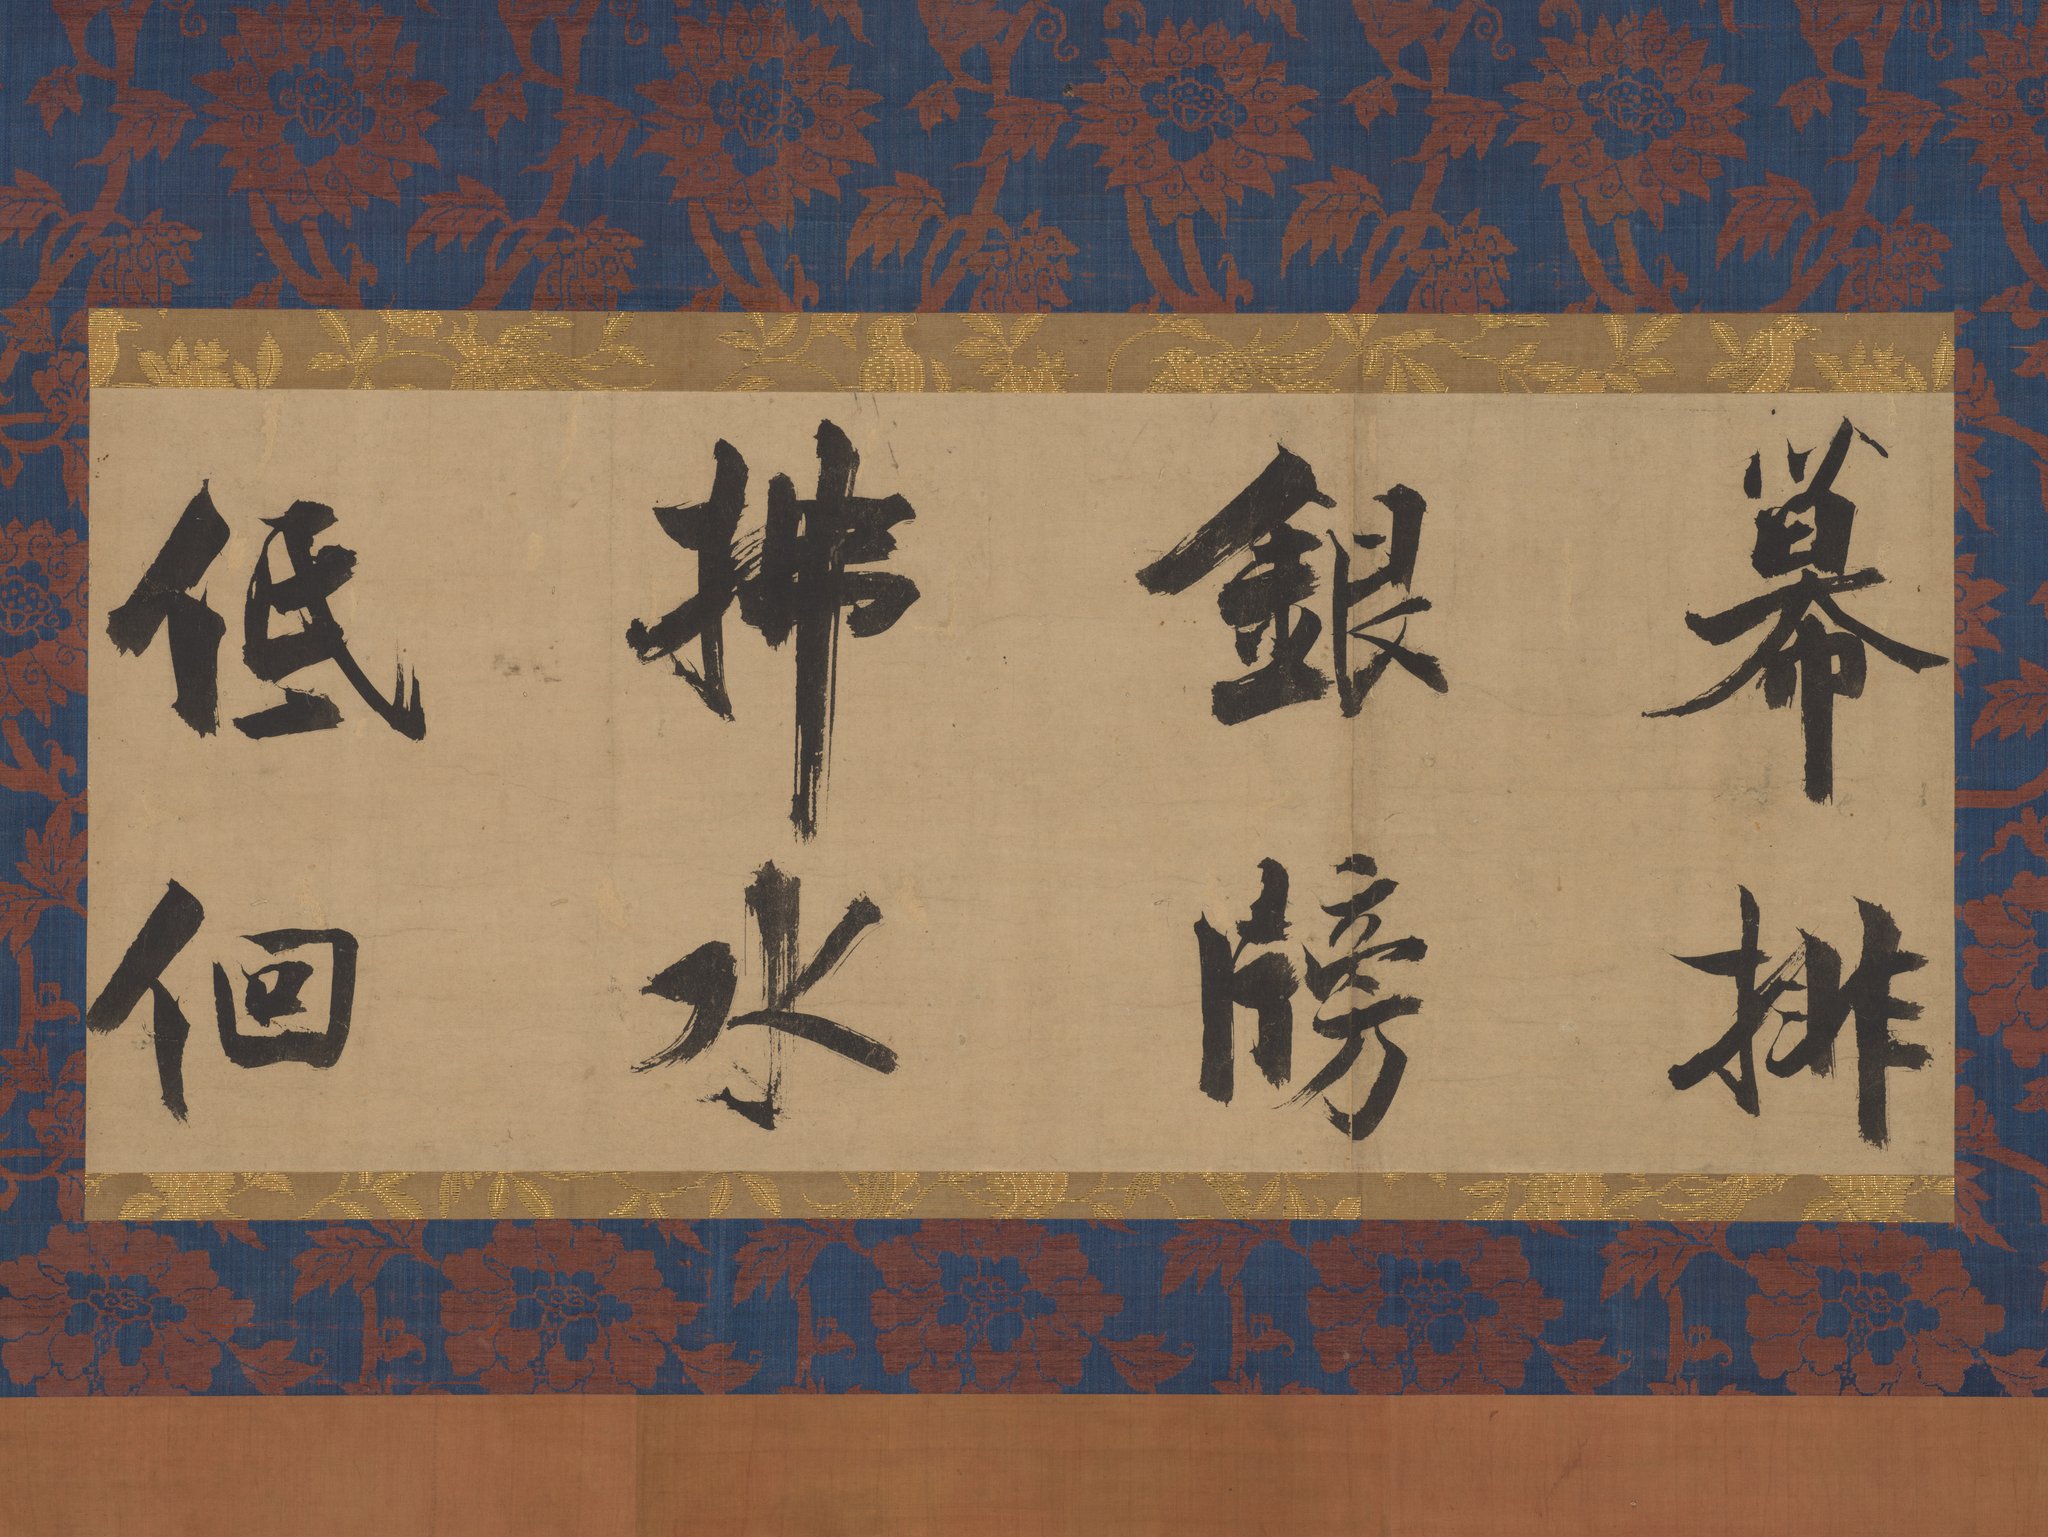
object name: hanging scroll mounted a handscroll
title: Excerpt from “Song of Leyou Park”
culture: chinese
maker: zhang jizhi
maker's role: artist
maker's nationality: chinese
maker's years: 1186-1266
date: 1201-1300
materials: ink, paper